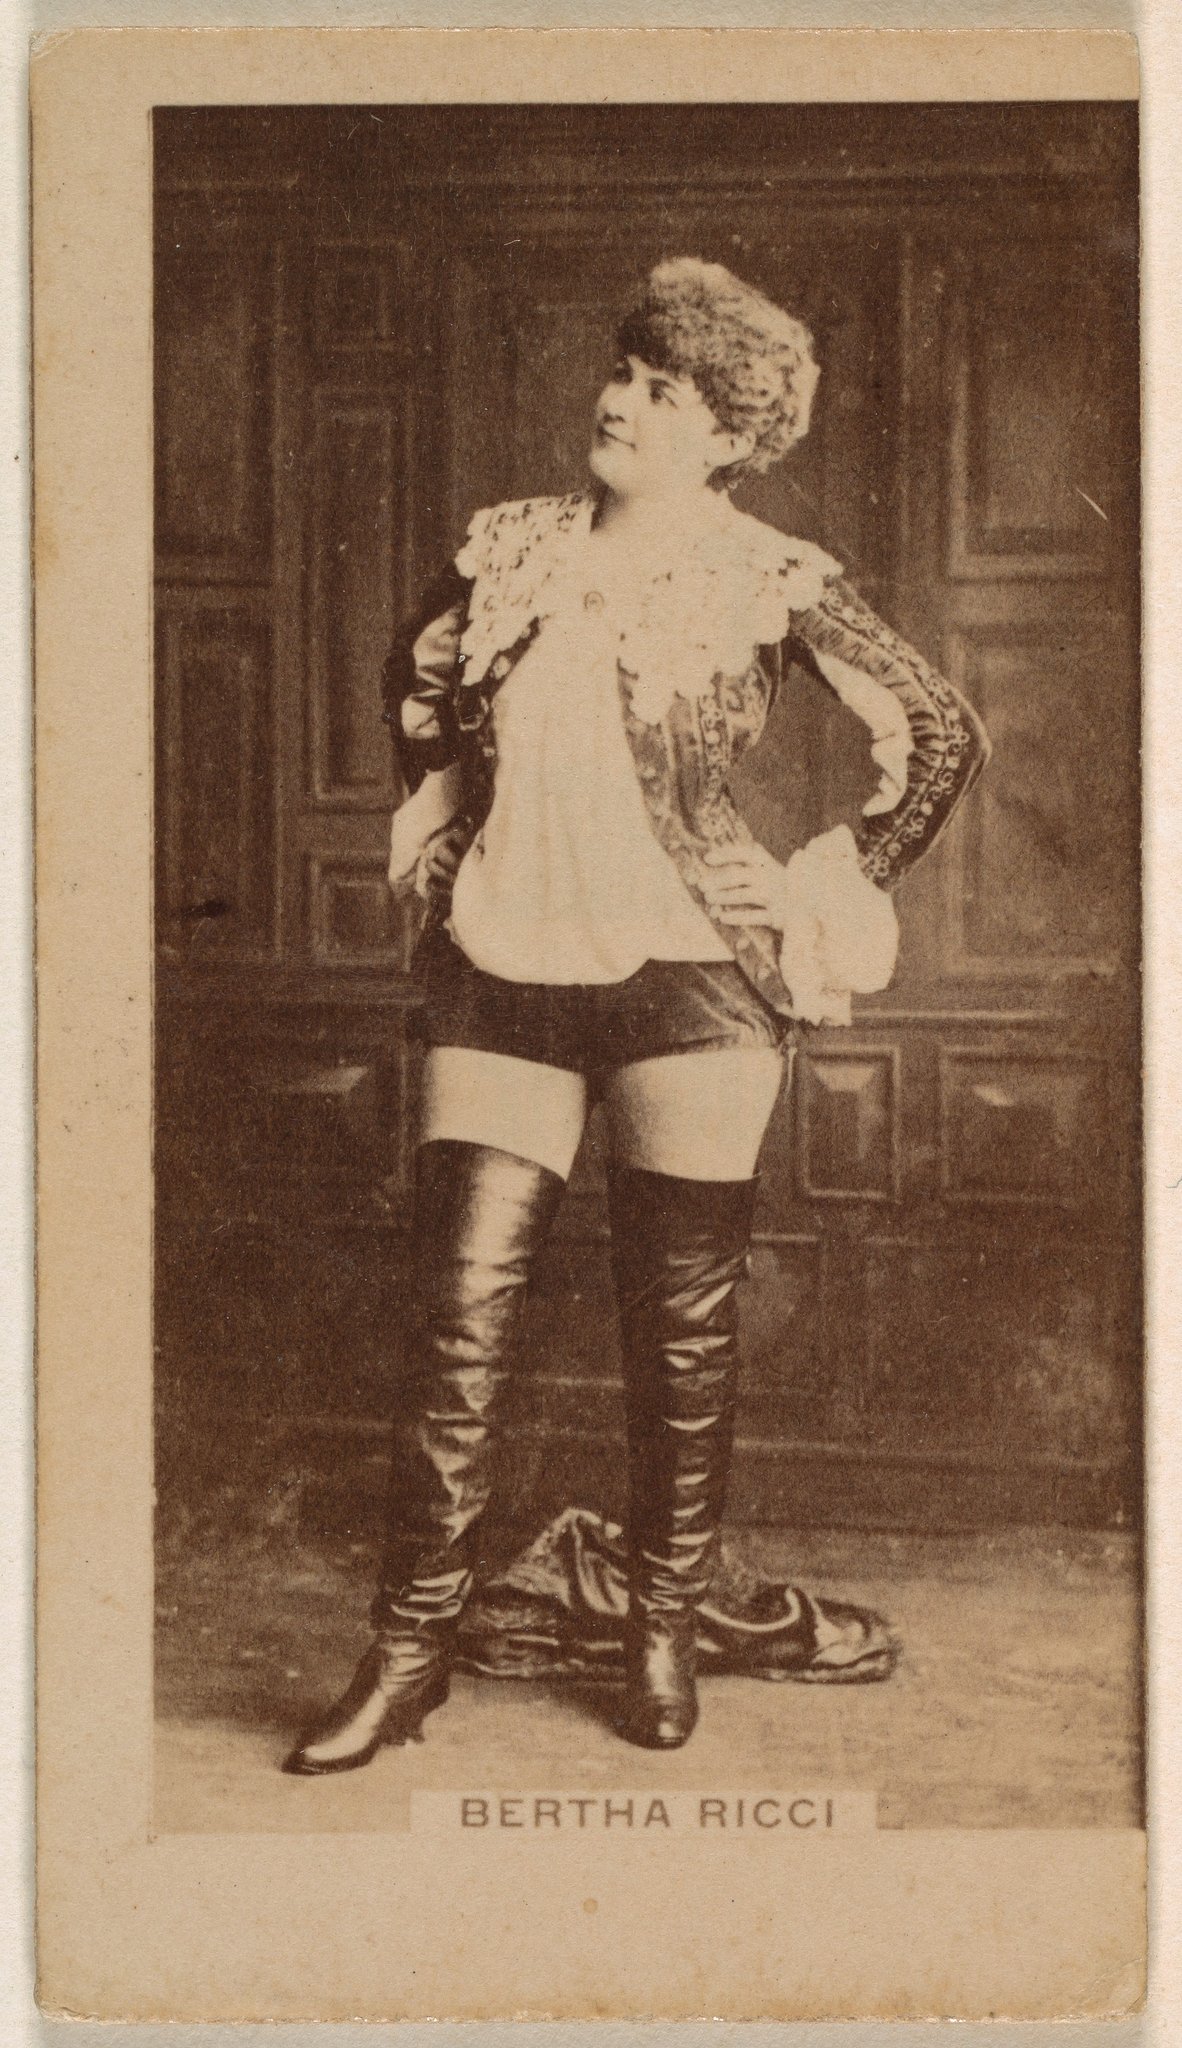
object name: photograph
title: Bertha Ricci, from the Actresses series (N245) issued by Kinney Brothers to promote Sweet Caporal Cigarettes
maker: kinney brothers tobacco company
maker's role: publisher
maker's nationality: american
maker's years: 1869-2011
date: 1890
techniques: albumen silver print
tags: portraits,women,actresses